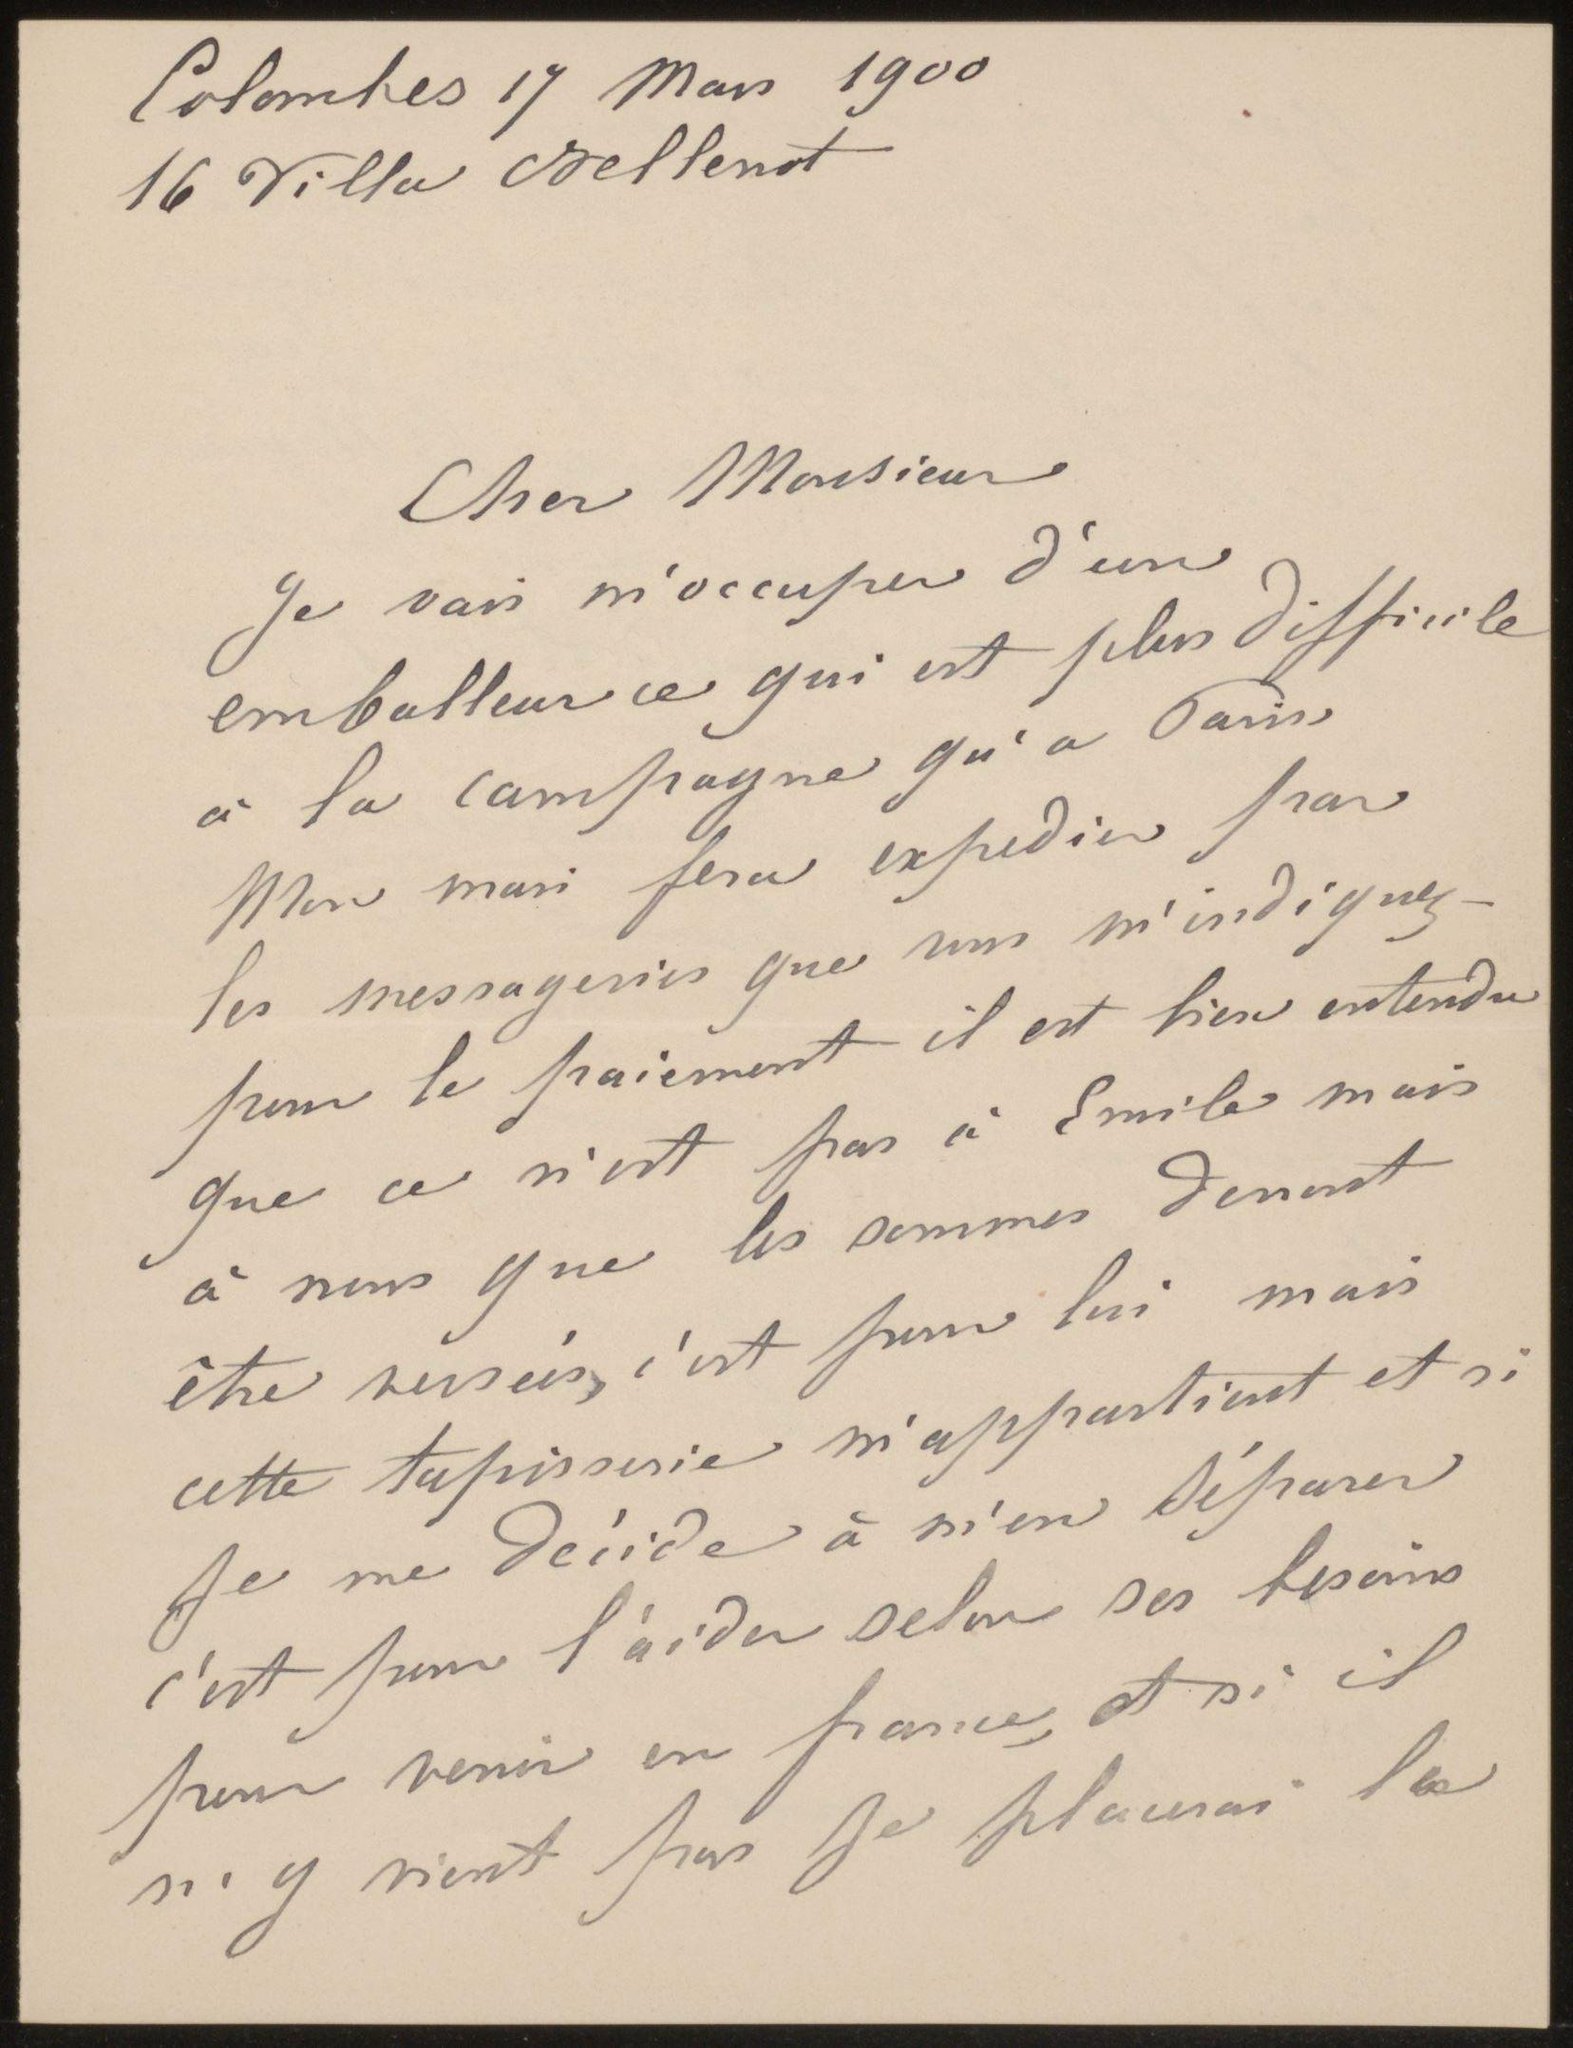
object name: letter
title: Brief aan Andries Bonger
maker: héloïse bernard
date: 1900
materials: ink, paper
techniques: pen, writing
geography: colombes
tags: paris, print maker, émile bernard, amsterdam, andries bonger, applied arts, arts and crafts; industrial design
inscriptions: watermark